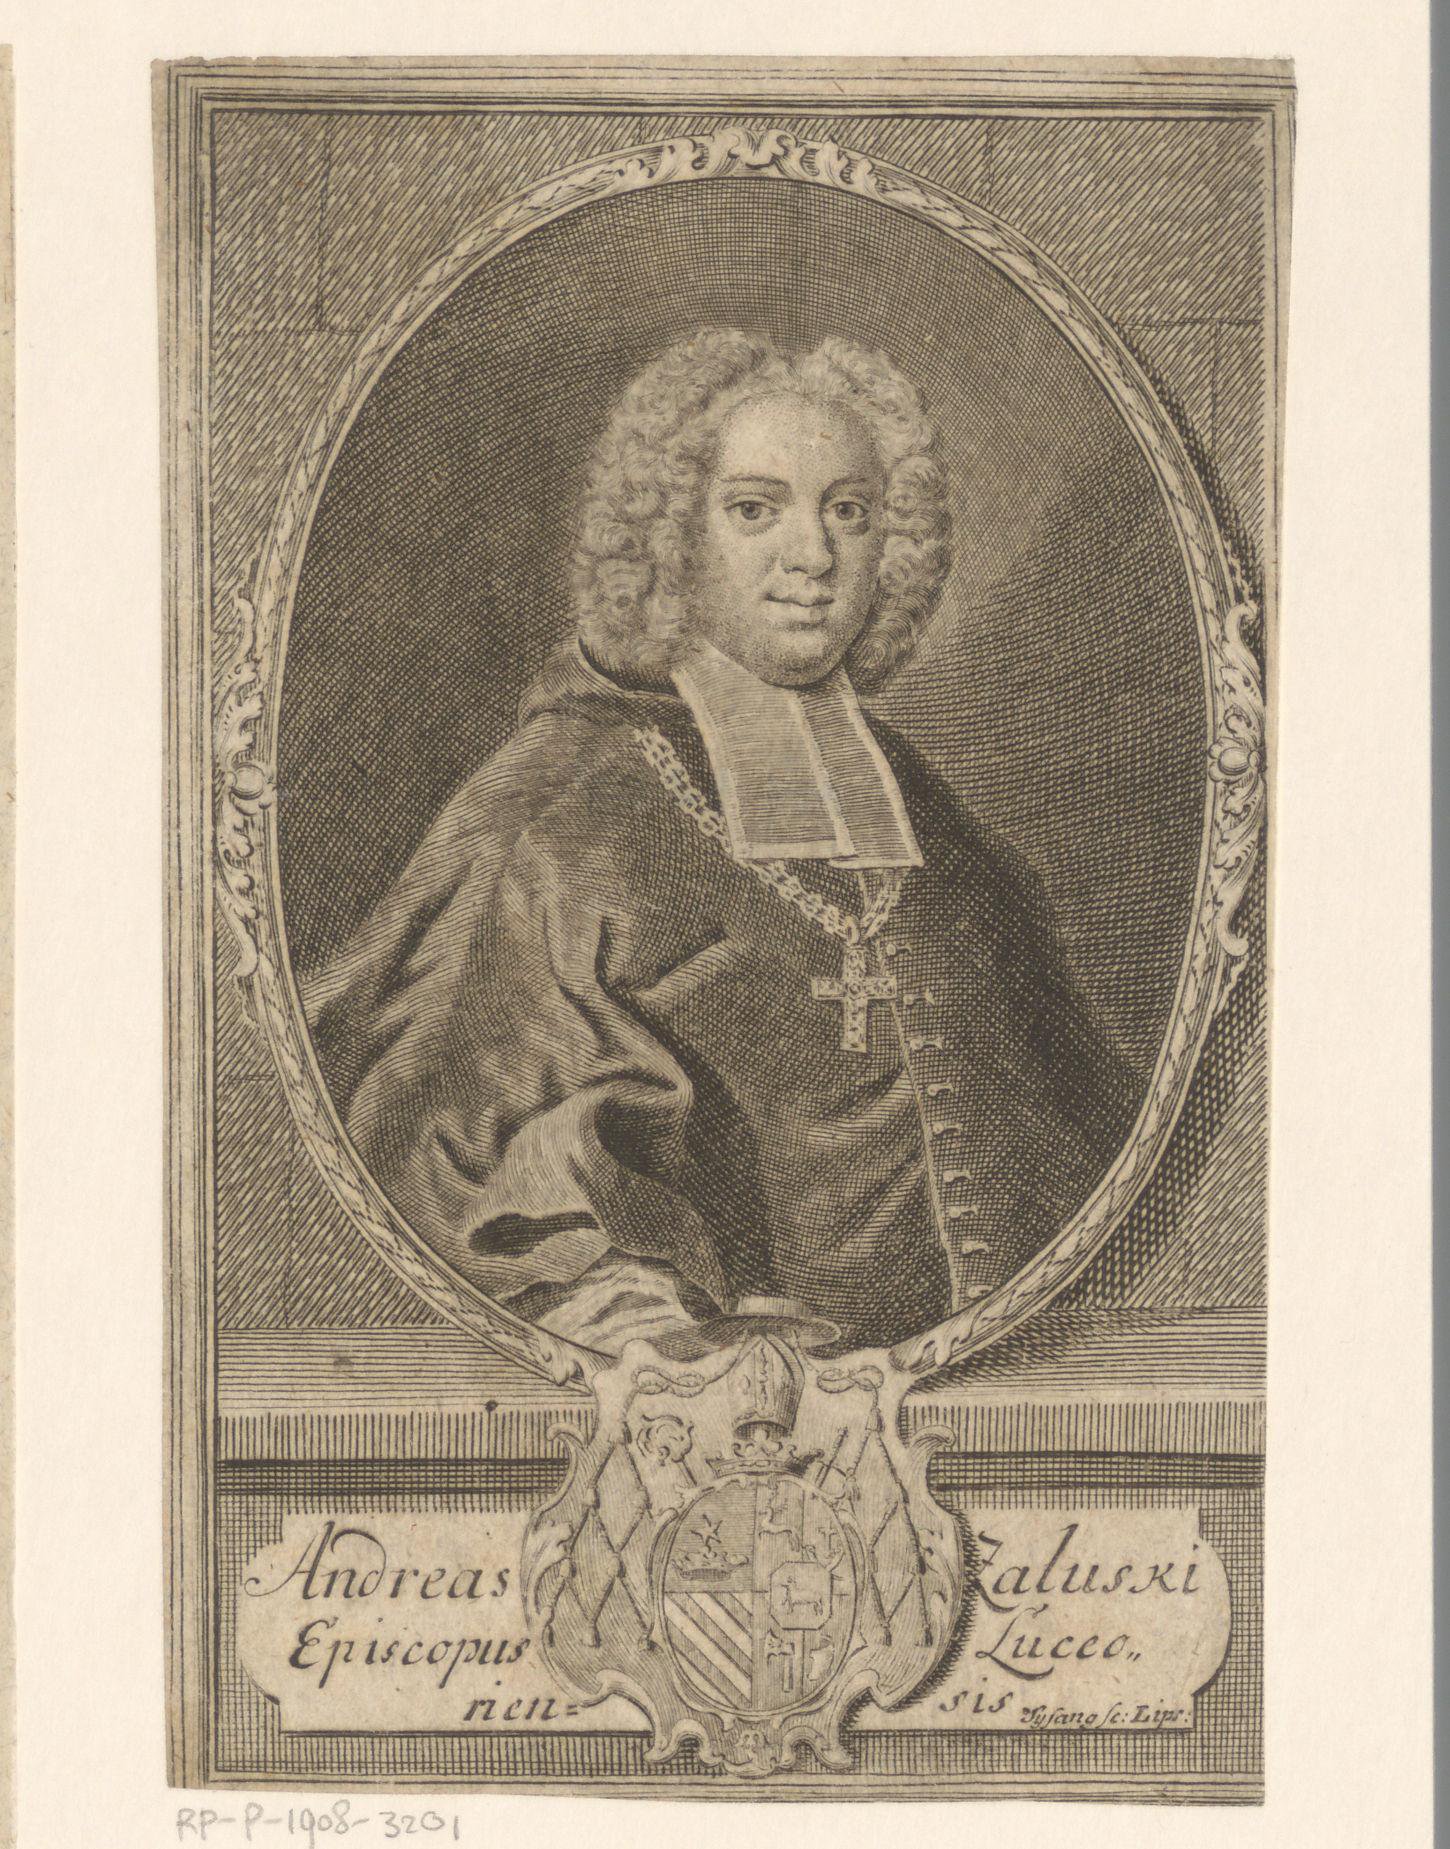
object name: print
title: Portret van Andrzej Stanisław Kostka, Graf Załuski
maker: johann christoph sysang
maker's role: print maker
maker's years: 1703-1757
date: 1734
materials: paper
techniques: engraving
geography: leipzig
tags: andrzej stanisław kostka graf załuski, archbishop, bishop, etc. (roman catholic), historical persons, armorial bearing, heraldry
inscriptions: collector's mark: Lugt 2228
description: Prent gebruikt voor de publicatie: Europäischer Staats-Secretarius. Leipzig: Moritz Georg II Weidmann, 1734, dl. 7.